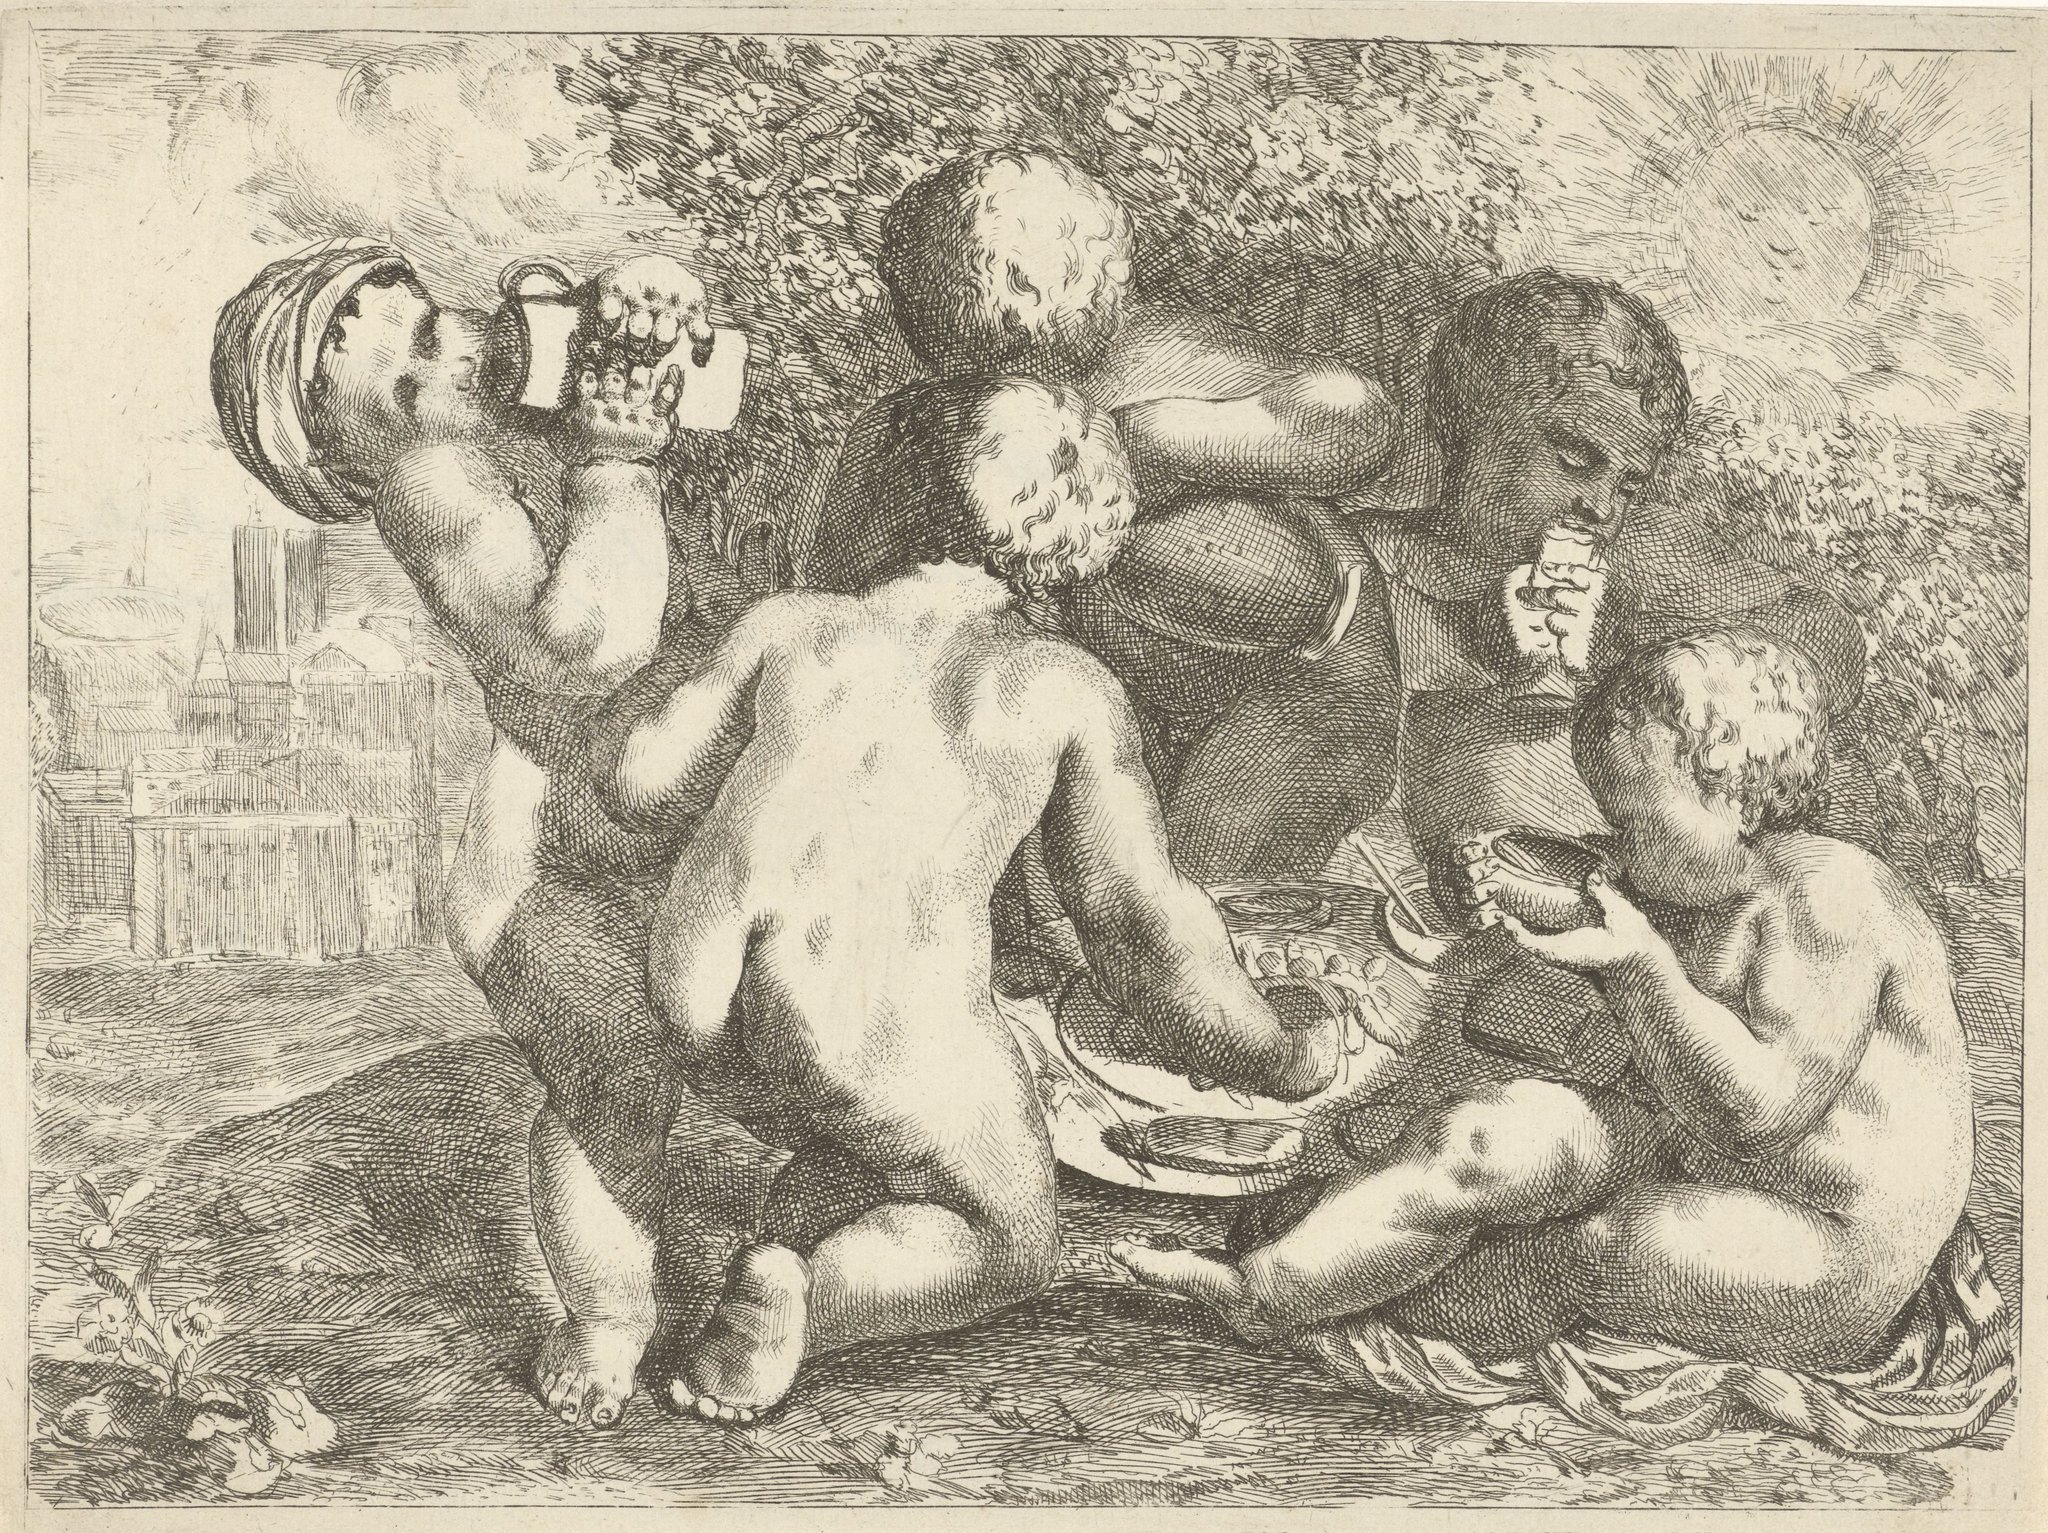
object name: print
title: Bacchanaal met vijf putti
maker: pieter van der plas (ii)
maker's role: print maker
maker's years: 1647-1708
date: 1687-1708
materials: paper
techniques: engraving, etching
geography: northern netherlands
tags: children's bacchanal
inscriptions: collector's mark: Lugt 2228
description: Landschap met vijf naakte putti die eten en drinken. Links op de achtergrond een gezicht op een stad. Rechts de opkomende zon.